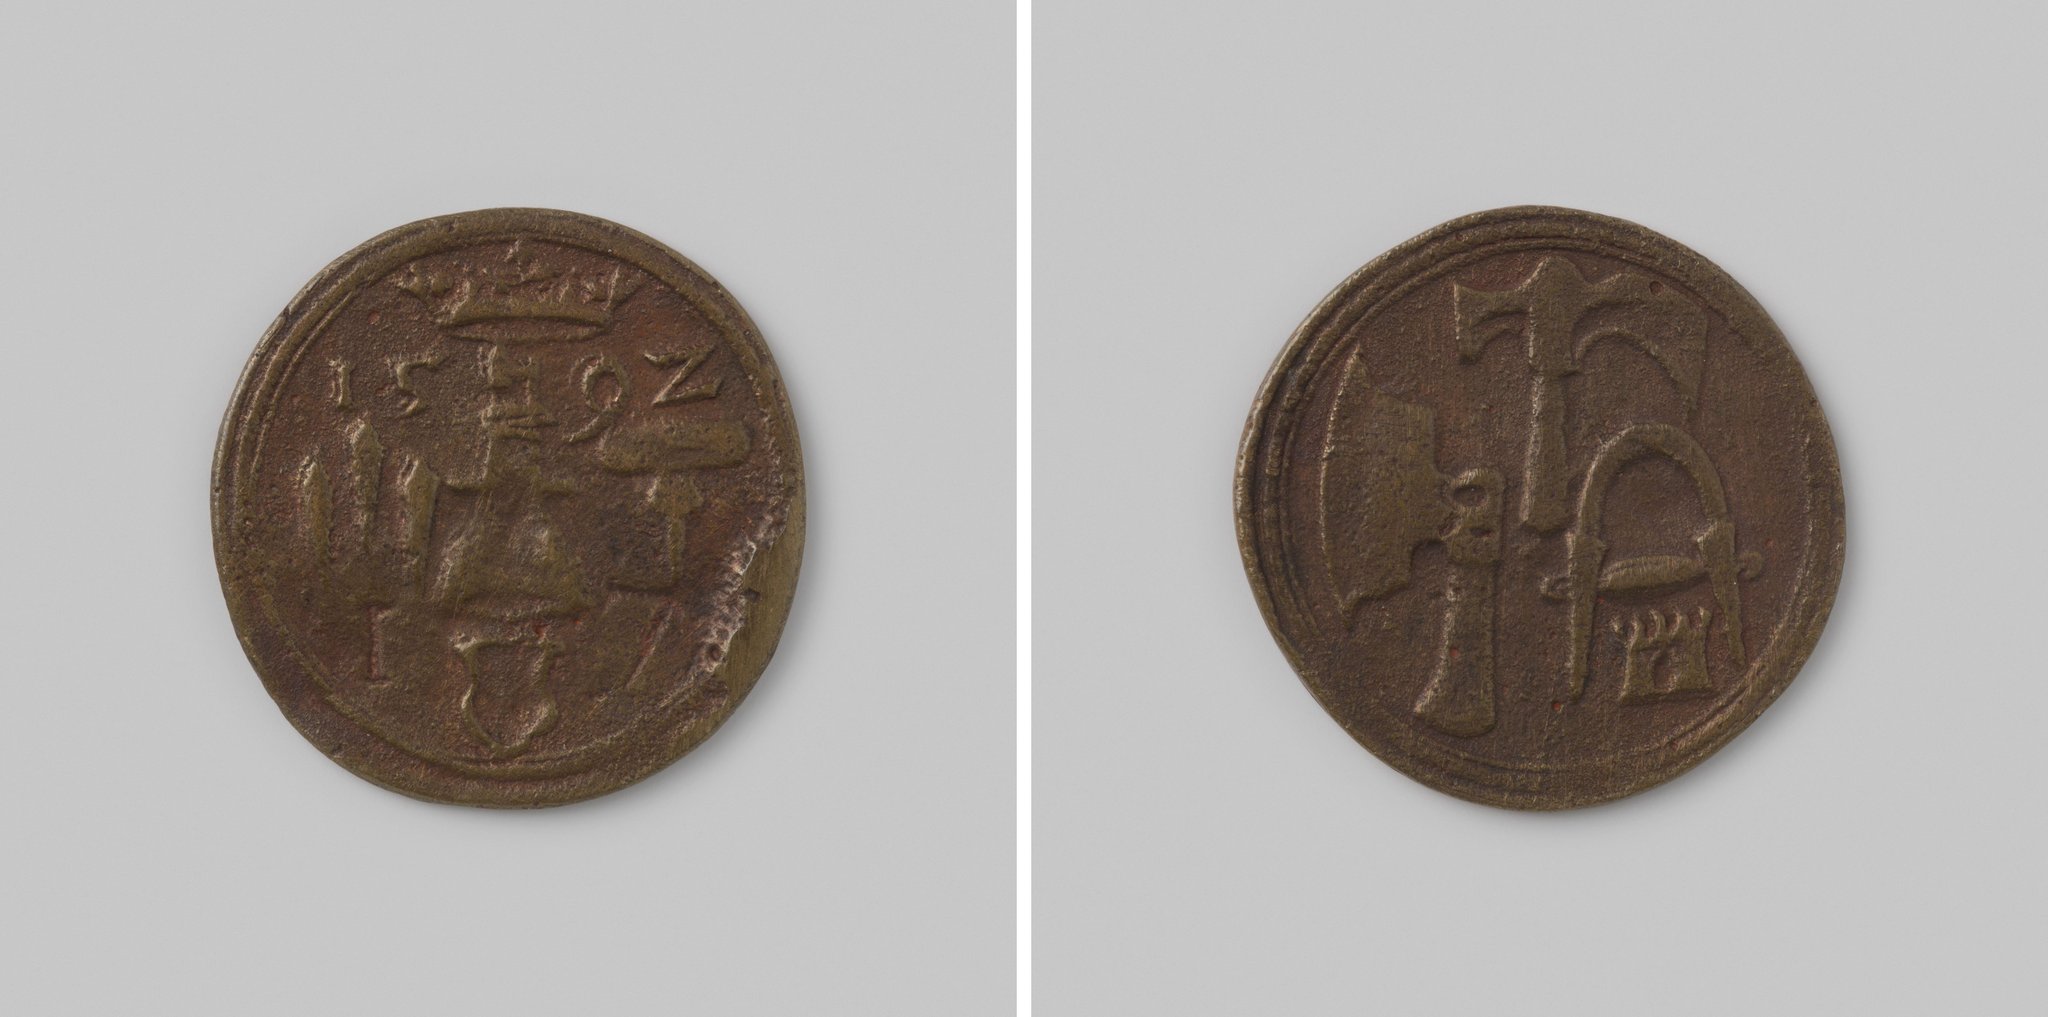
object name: medal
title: Presentiepenning van het Kuipersgilde te Middelburg, 1592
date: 1592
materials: brass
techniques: striking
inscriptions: inscription: ‘17’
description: Geslagen messing penning, op de voorzijde een gekroond aambeeld, drie aandrijvers, een boor en een wapenschildje, boven het jaartal 1592, onder gegraveerd het getal 17, op de keerzijde bijl, hamer en een passer waaronder een burchtje